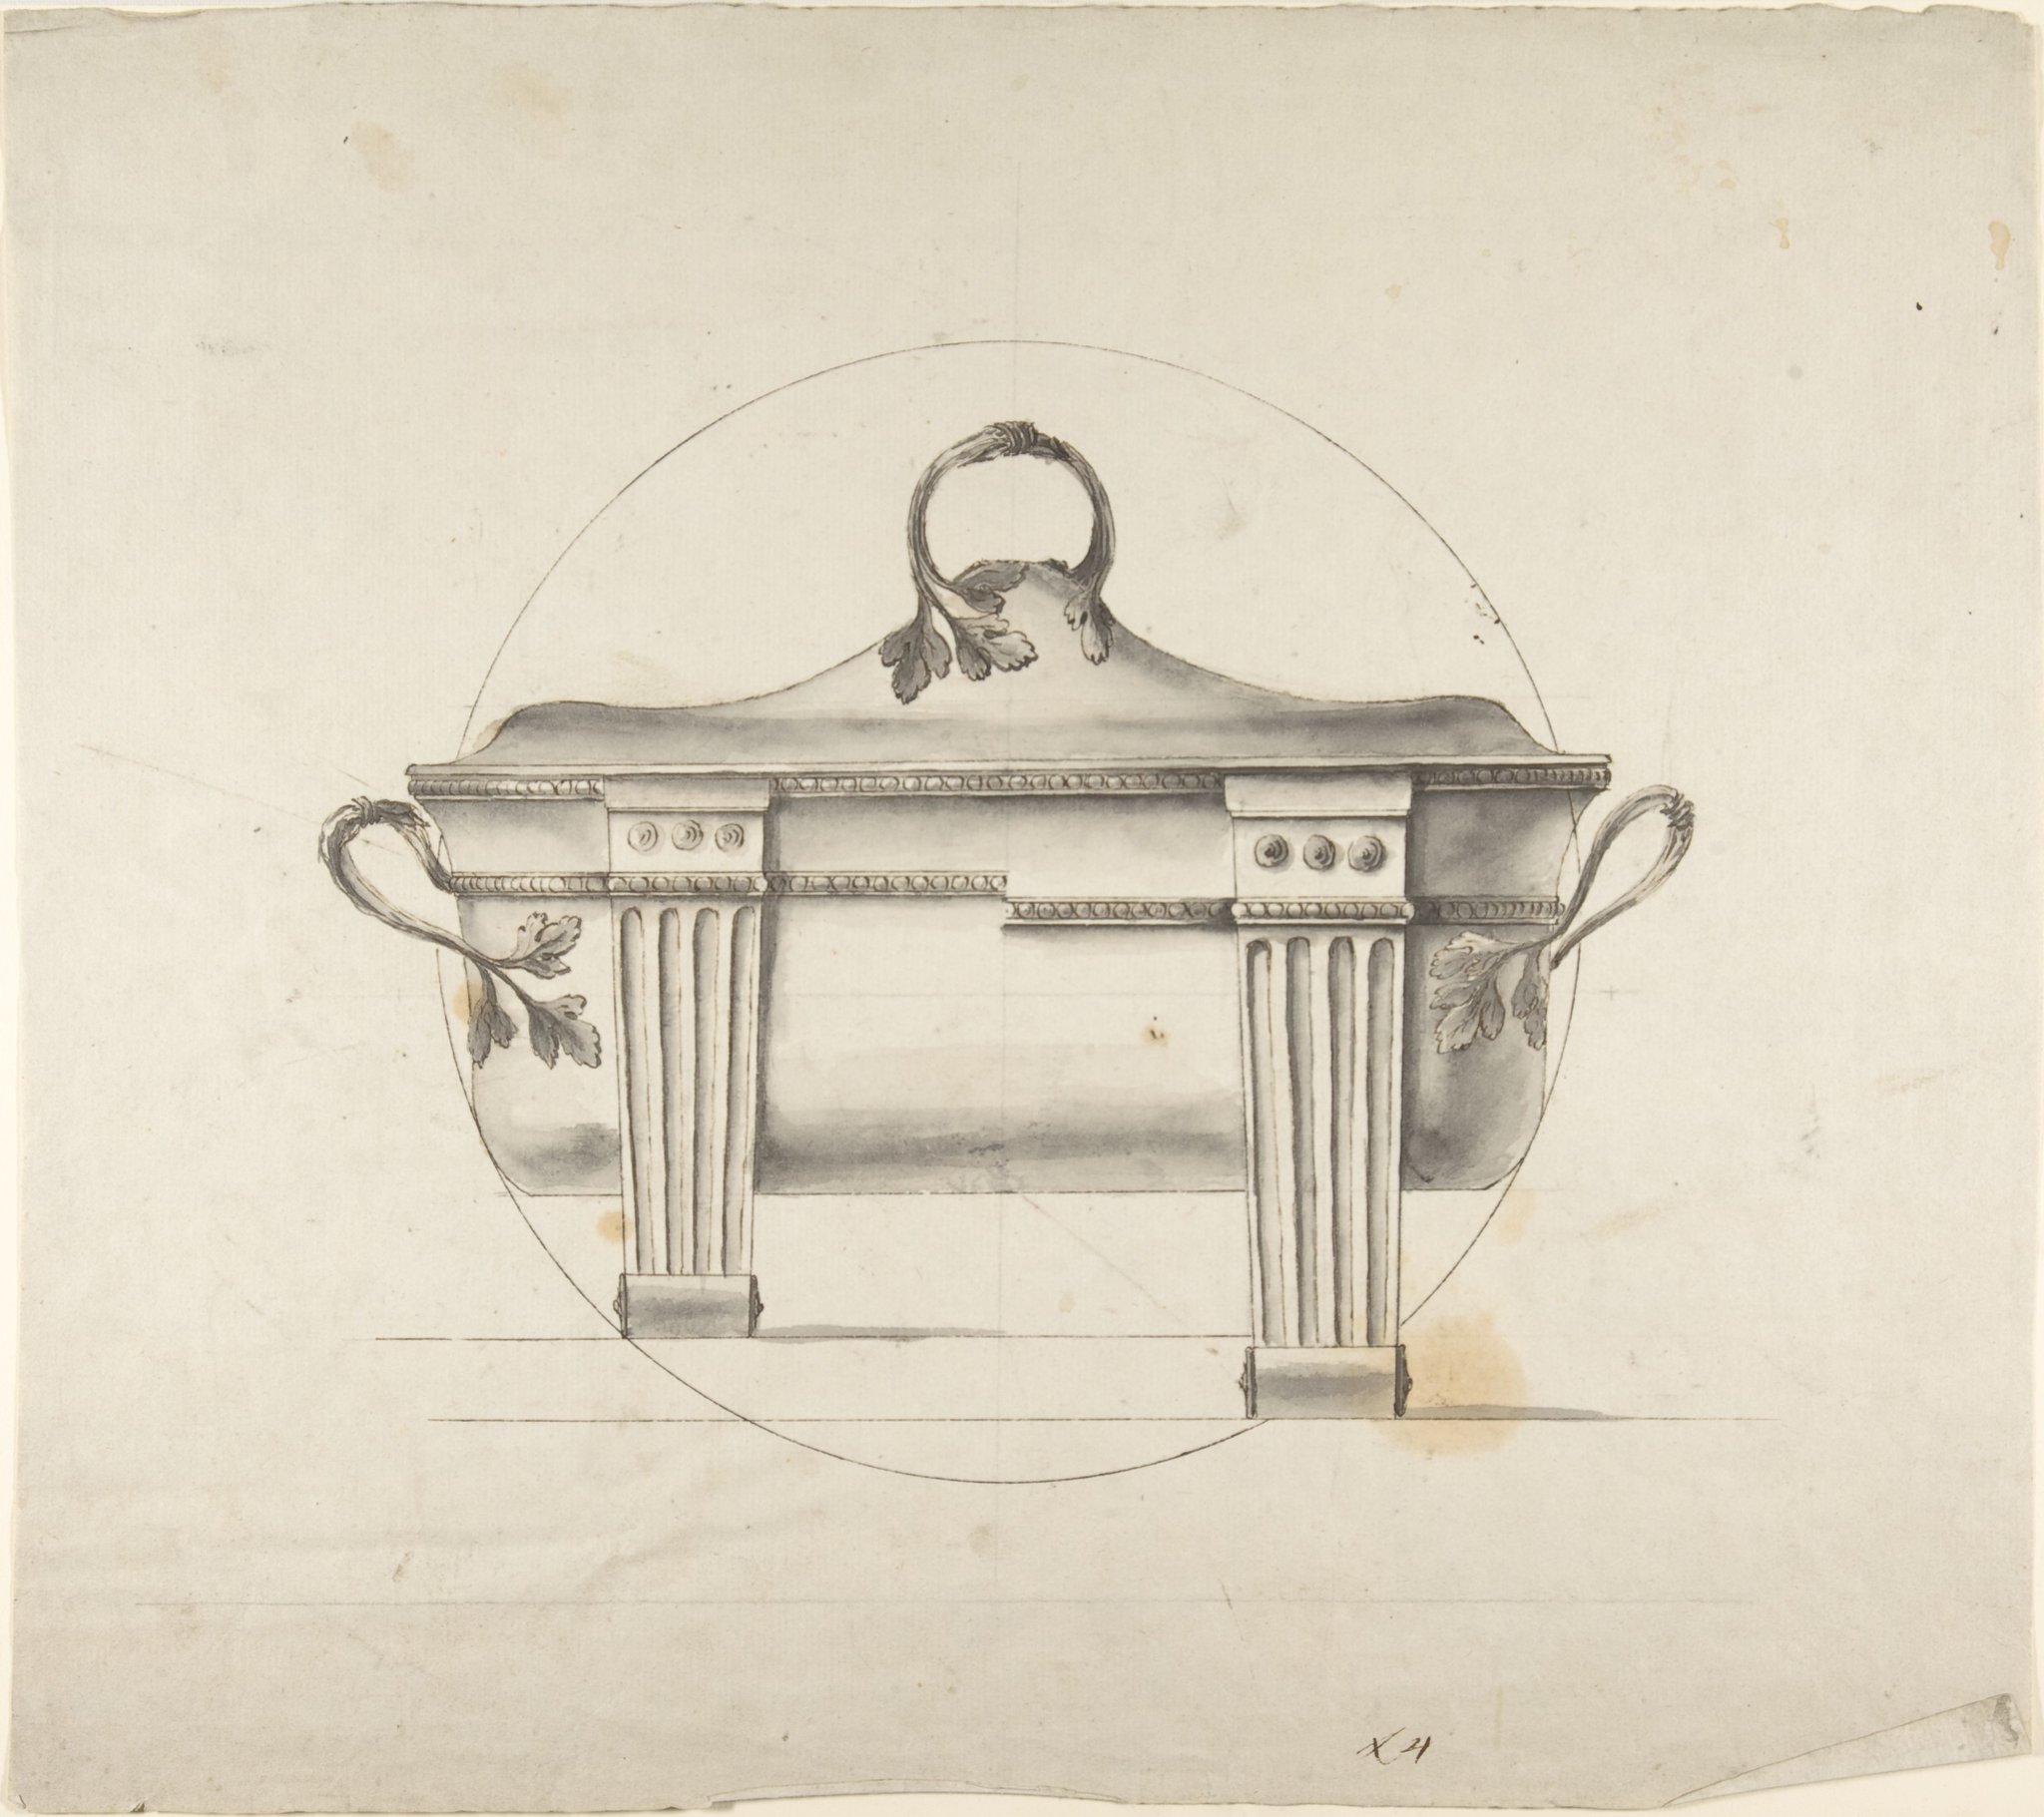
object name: drawing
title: Tureen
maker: anonymous, italian, 19th century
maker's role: artist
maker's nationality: italian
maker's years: 1800-1900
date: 1800-1900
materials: ink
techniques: pen, wash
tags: tureens